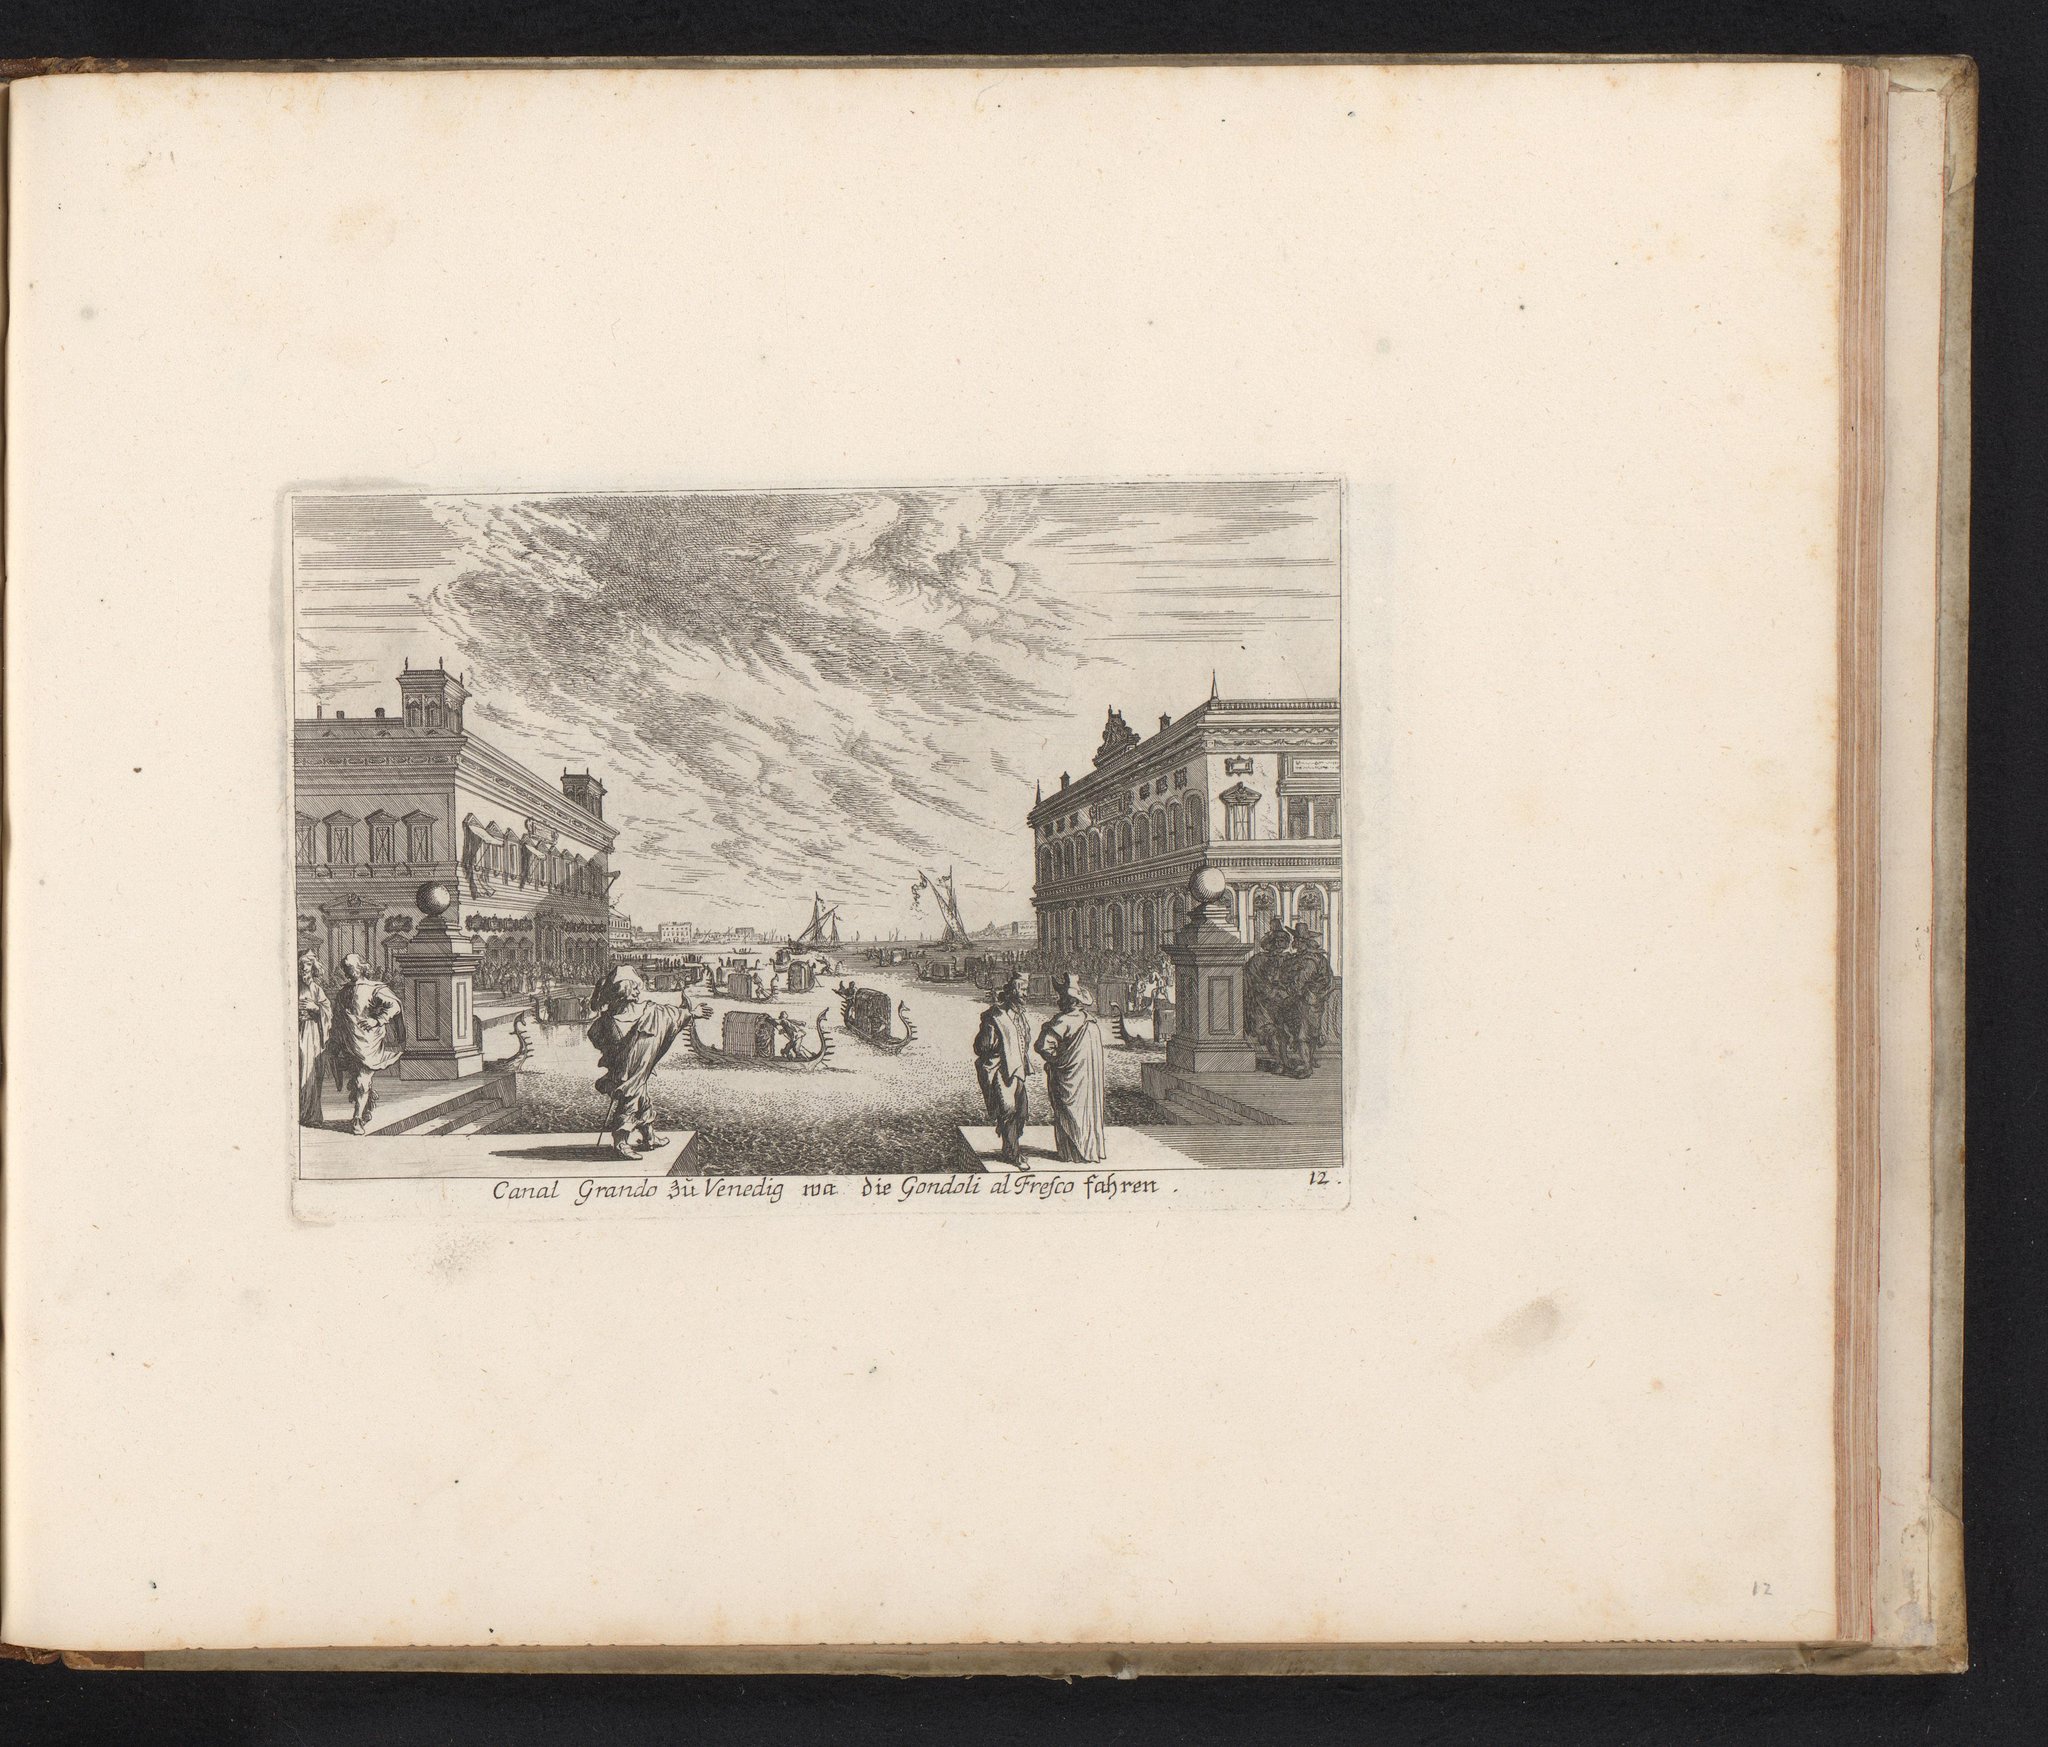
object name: album leaf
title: Gondels in het Canal Grande in Venetië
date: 1670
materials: paper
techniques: etching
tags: pier, quay, wharf, gondola, venice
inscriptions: collector's mark: Lugt 2228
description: Tekst in het Duits in de ondermarge. Rechtsonder genummerd: 12. Prent maakt deel uit van een album.